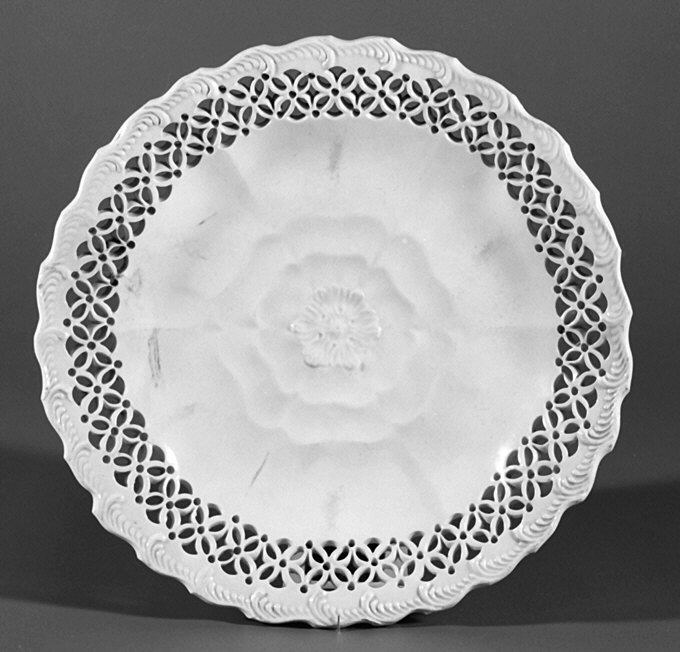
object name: dessert dish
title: Dessert dish (one of a pair)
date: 1701-1800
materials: creamware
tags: flowers